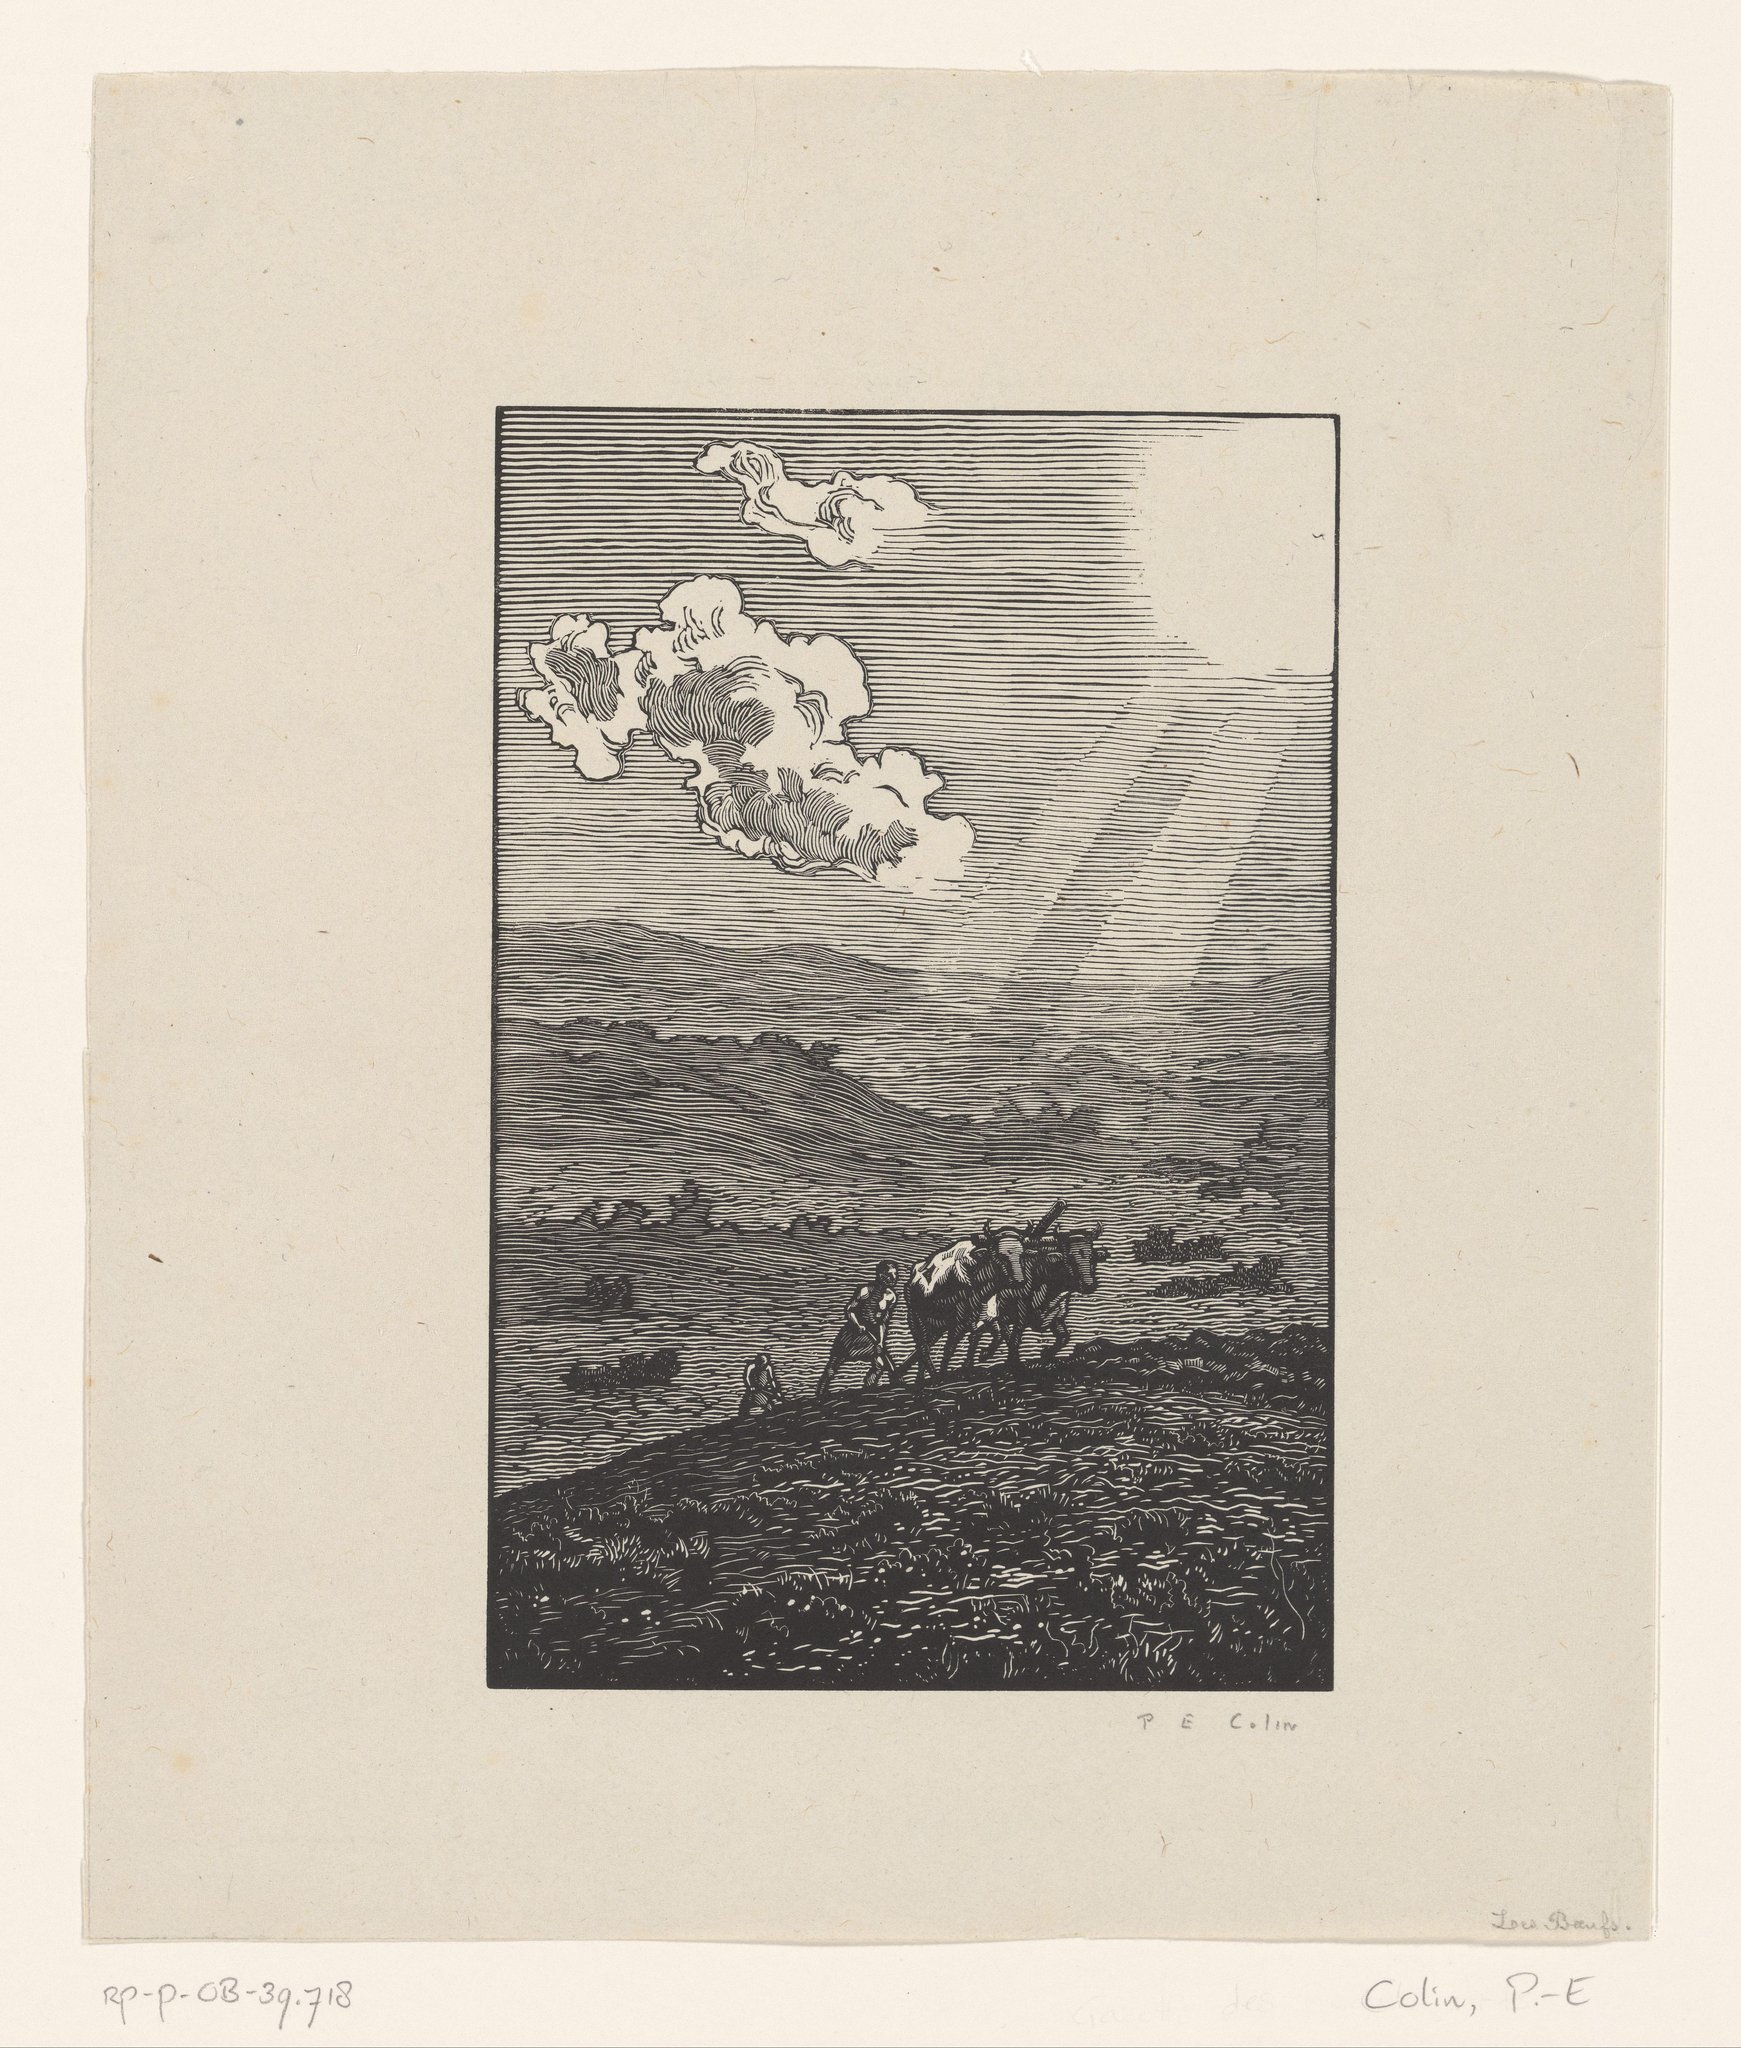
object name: print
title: Les Boeufs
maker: paul-emile colin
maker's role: print maker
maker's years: 1867-1949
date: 1913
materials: paper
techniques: woodcut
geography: paris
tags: ploughing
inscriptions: collector's mark: Lugt 2228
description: Prent uit: Gazette des Beaux Arts, 1913, p. 314.